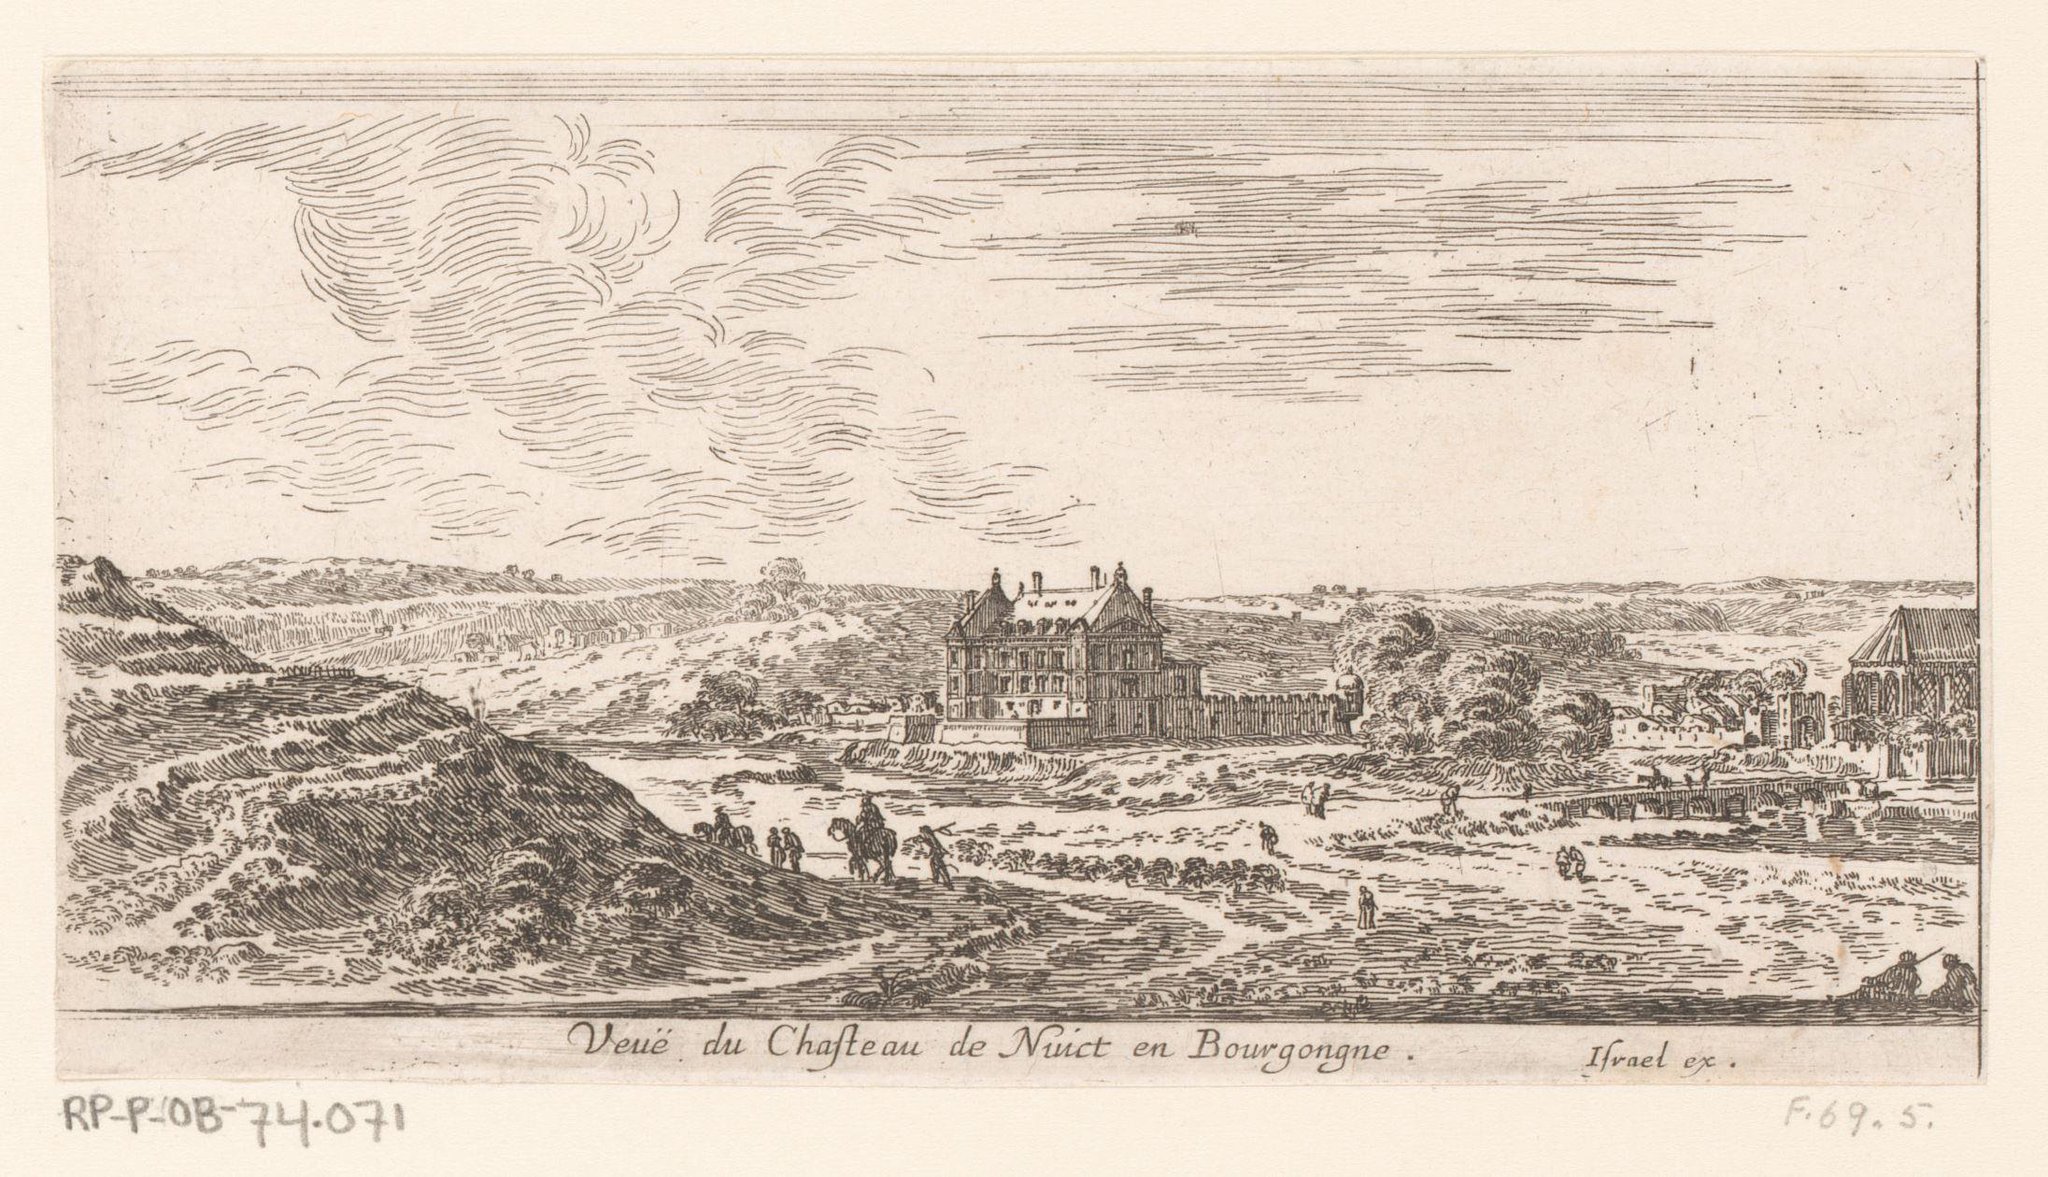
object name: print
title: Veue de Chasteau de Nuict en Bourgongne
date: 1650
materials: paper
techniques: etching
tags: landscape with tower or castle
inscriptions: collector's mark: Lugt 240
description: Prent maakt deel uit van een ongenummerde serie van twaalf prenten.